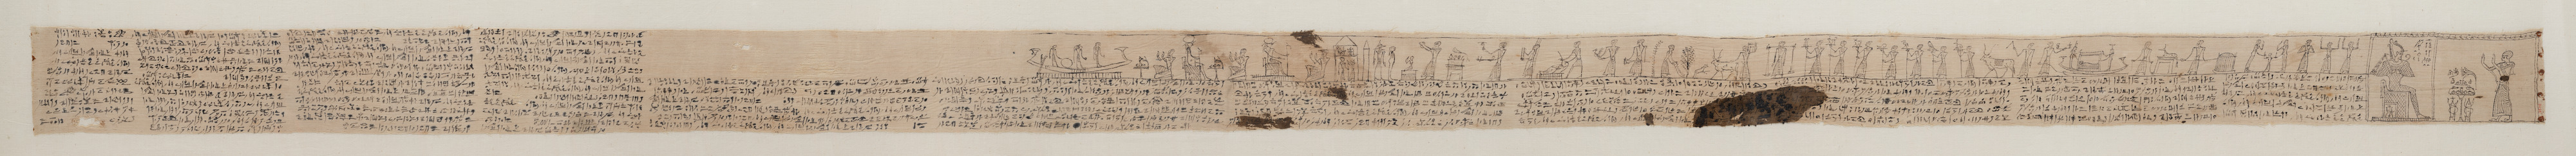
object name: linen mummy cloth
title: Mummy bandage of Hepmeneh, born of Tasheritentaqeri, inscribed with text and vignette from the Book of the Dead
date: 332-330 BCE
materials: ink, linen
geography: egypt